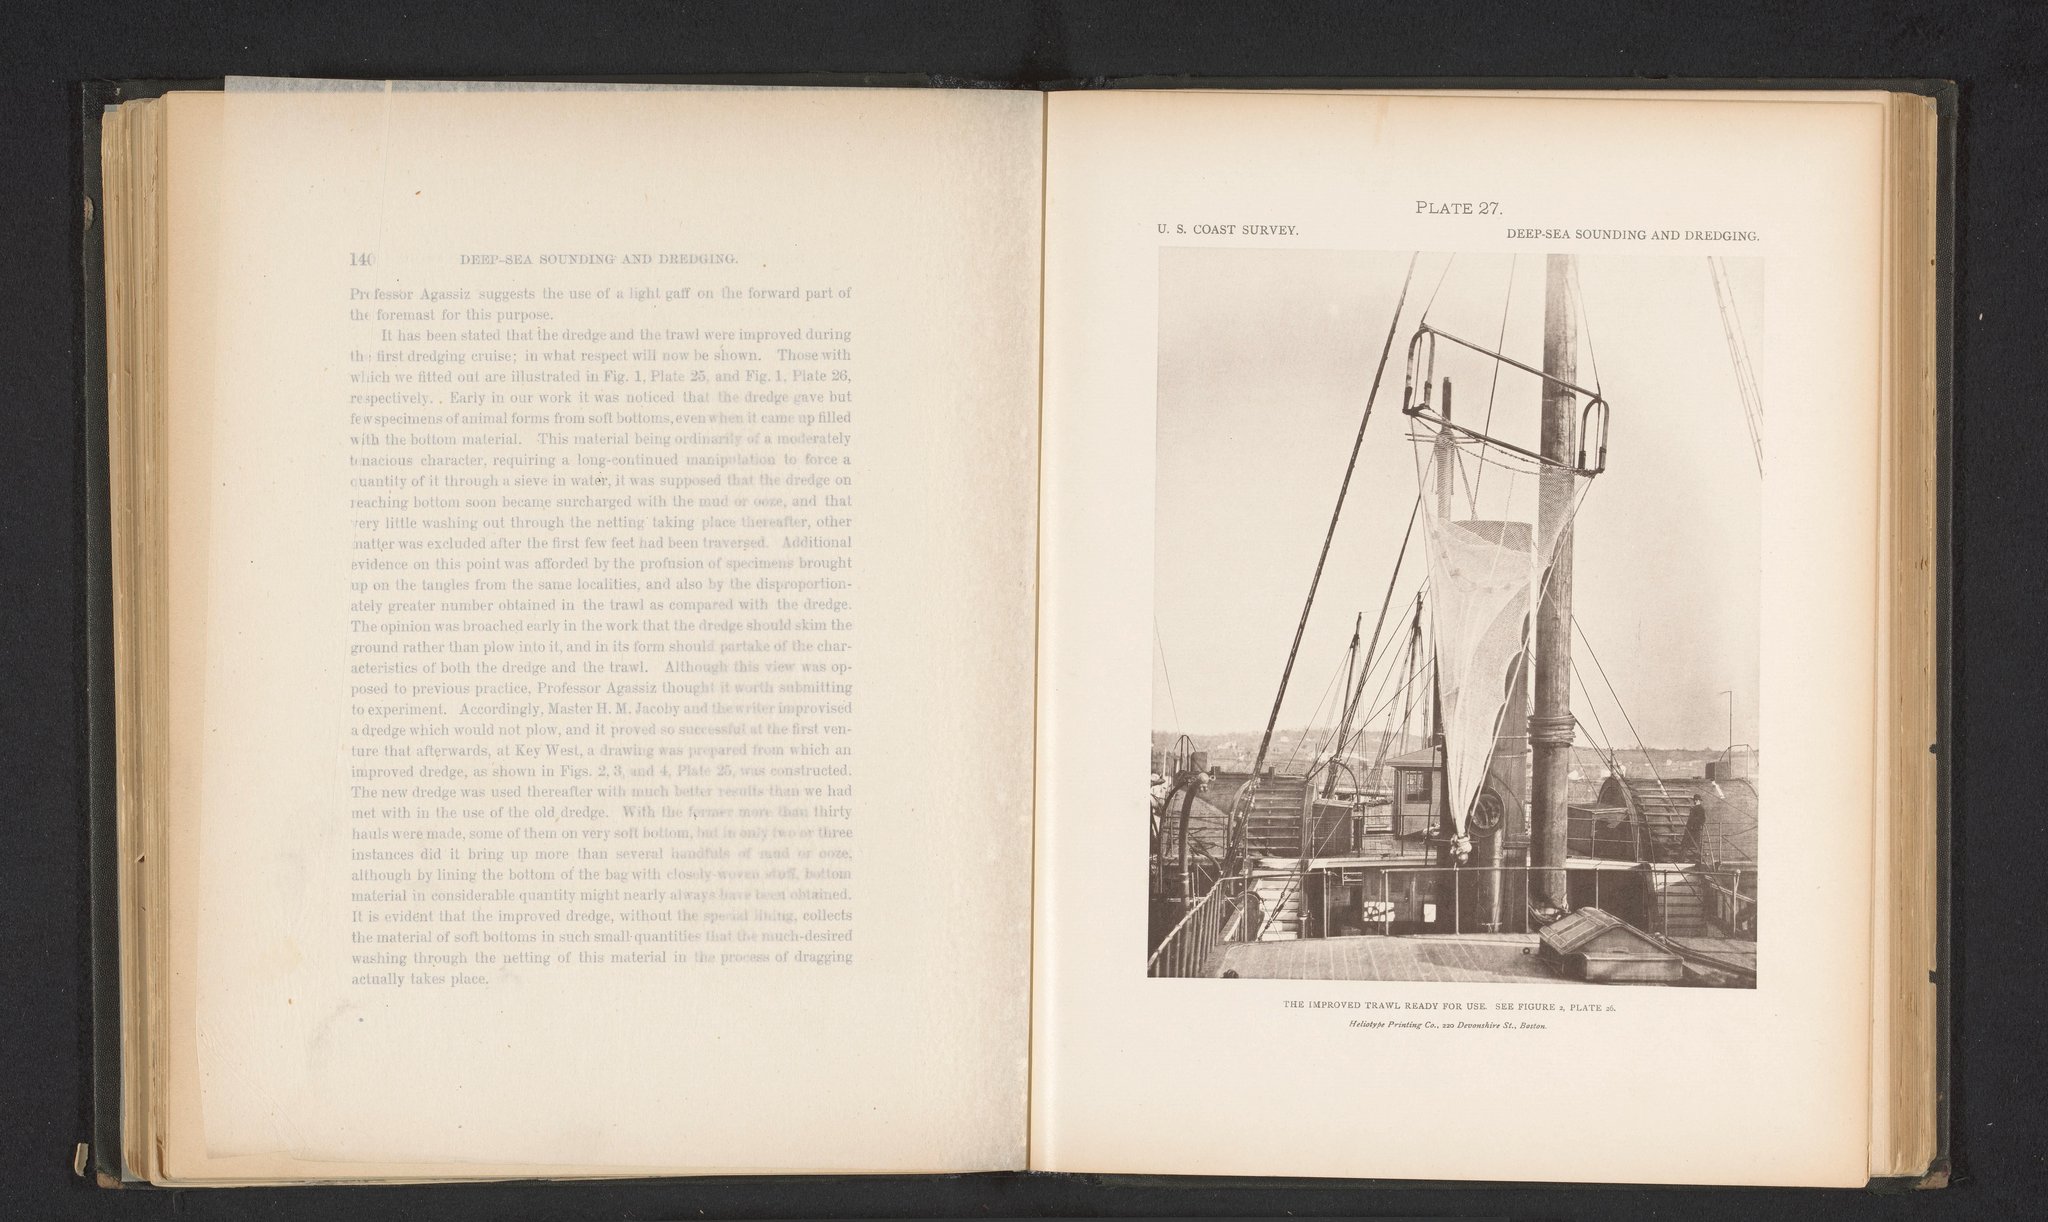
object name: page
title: Gezicht op een sleepnet op het dek van de George S. Blake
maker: Anonymous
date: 1870-1880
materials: paper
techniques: photograph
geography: boston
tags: fishing net, ships (in general)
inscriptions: inscription: ‘The improved trawl ready for use. See figure 2, plate 26.’, number: ‘Plate 27.’, name: ‘Heliotype Printing Co., 220 Devonshire St., Boston.’